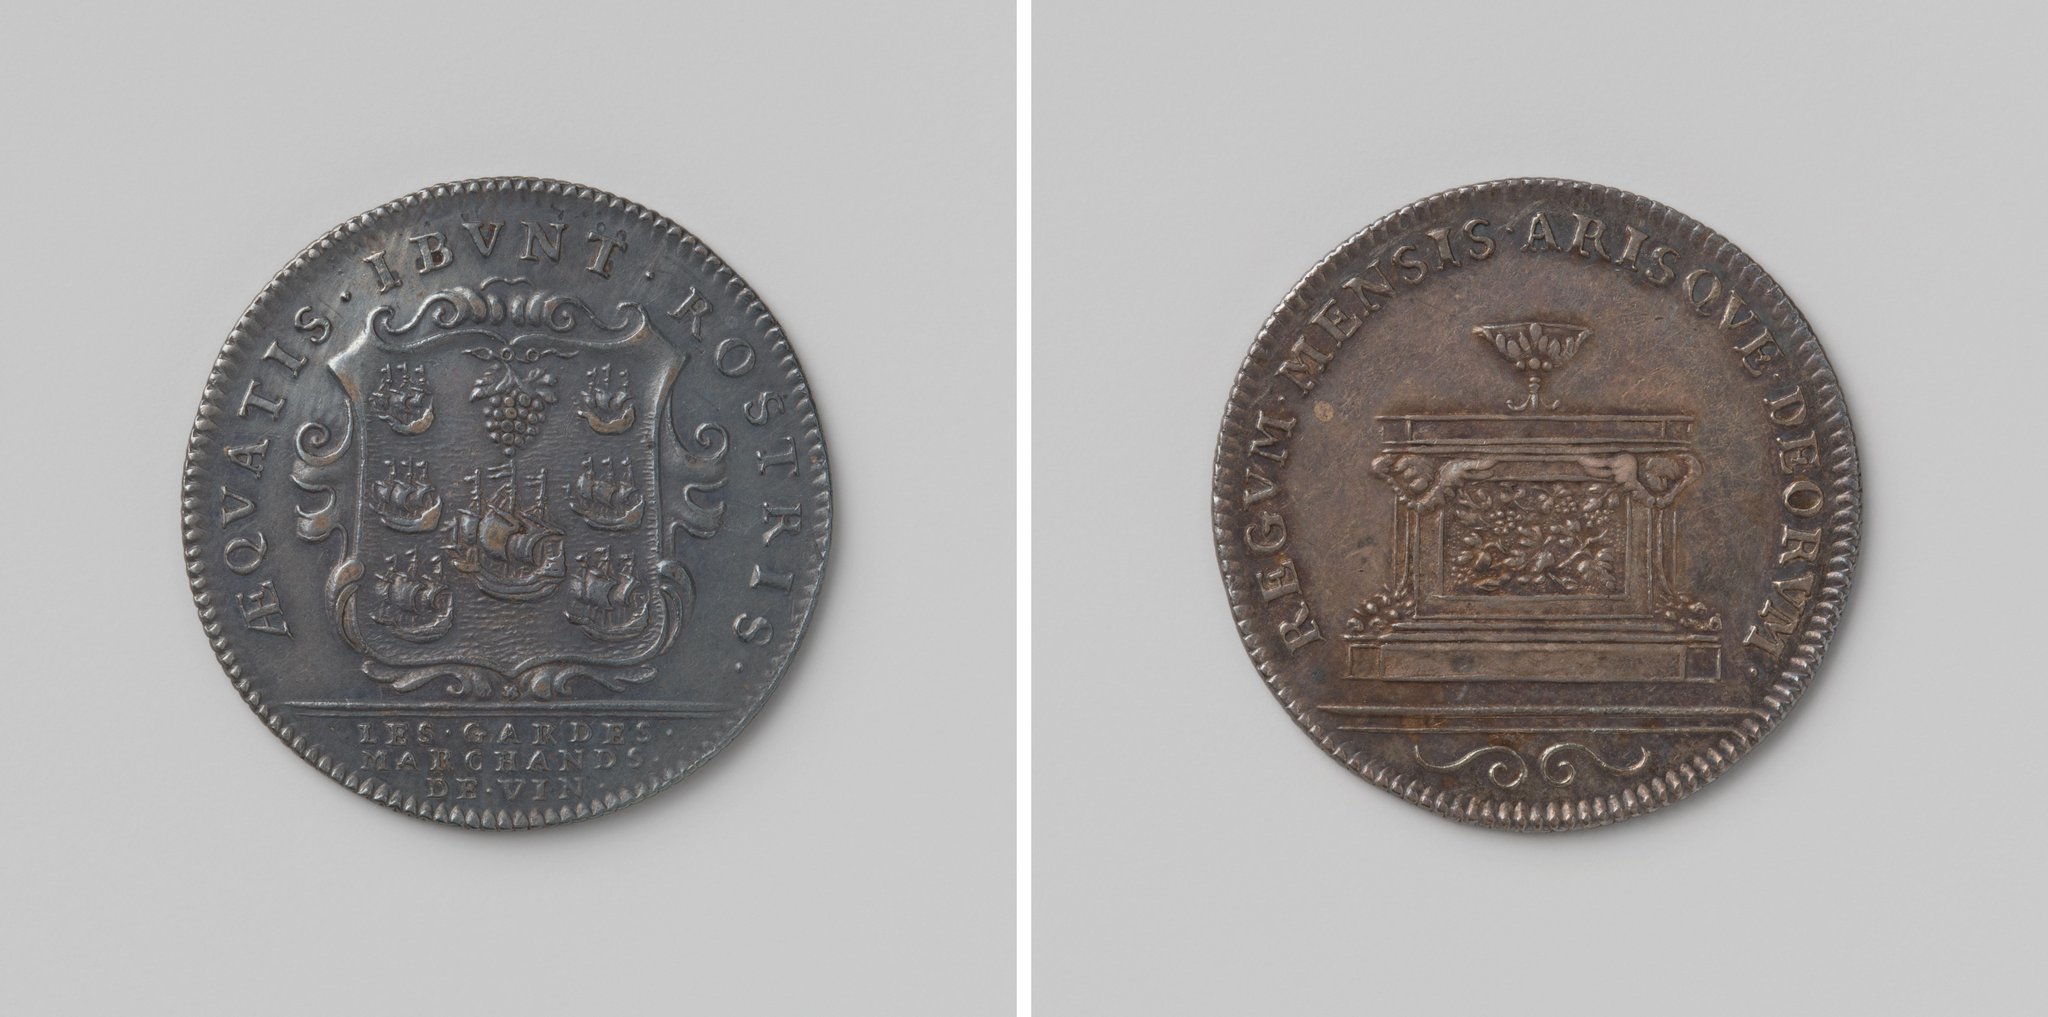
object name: jeton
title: Gardes Marchands de vin van Parijs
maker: Anonymous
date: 1650-1800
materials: silver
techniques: striking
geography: paris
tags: paris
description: Zilveren penning. Voorzijde: wapenschild in cartouche binnen omschrift; afsnede: opschrift. Keerzijde: kelk staande op altaar binnen omschrift